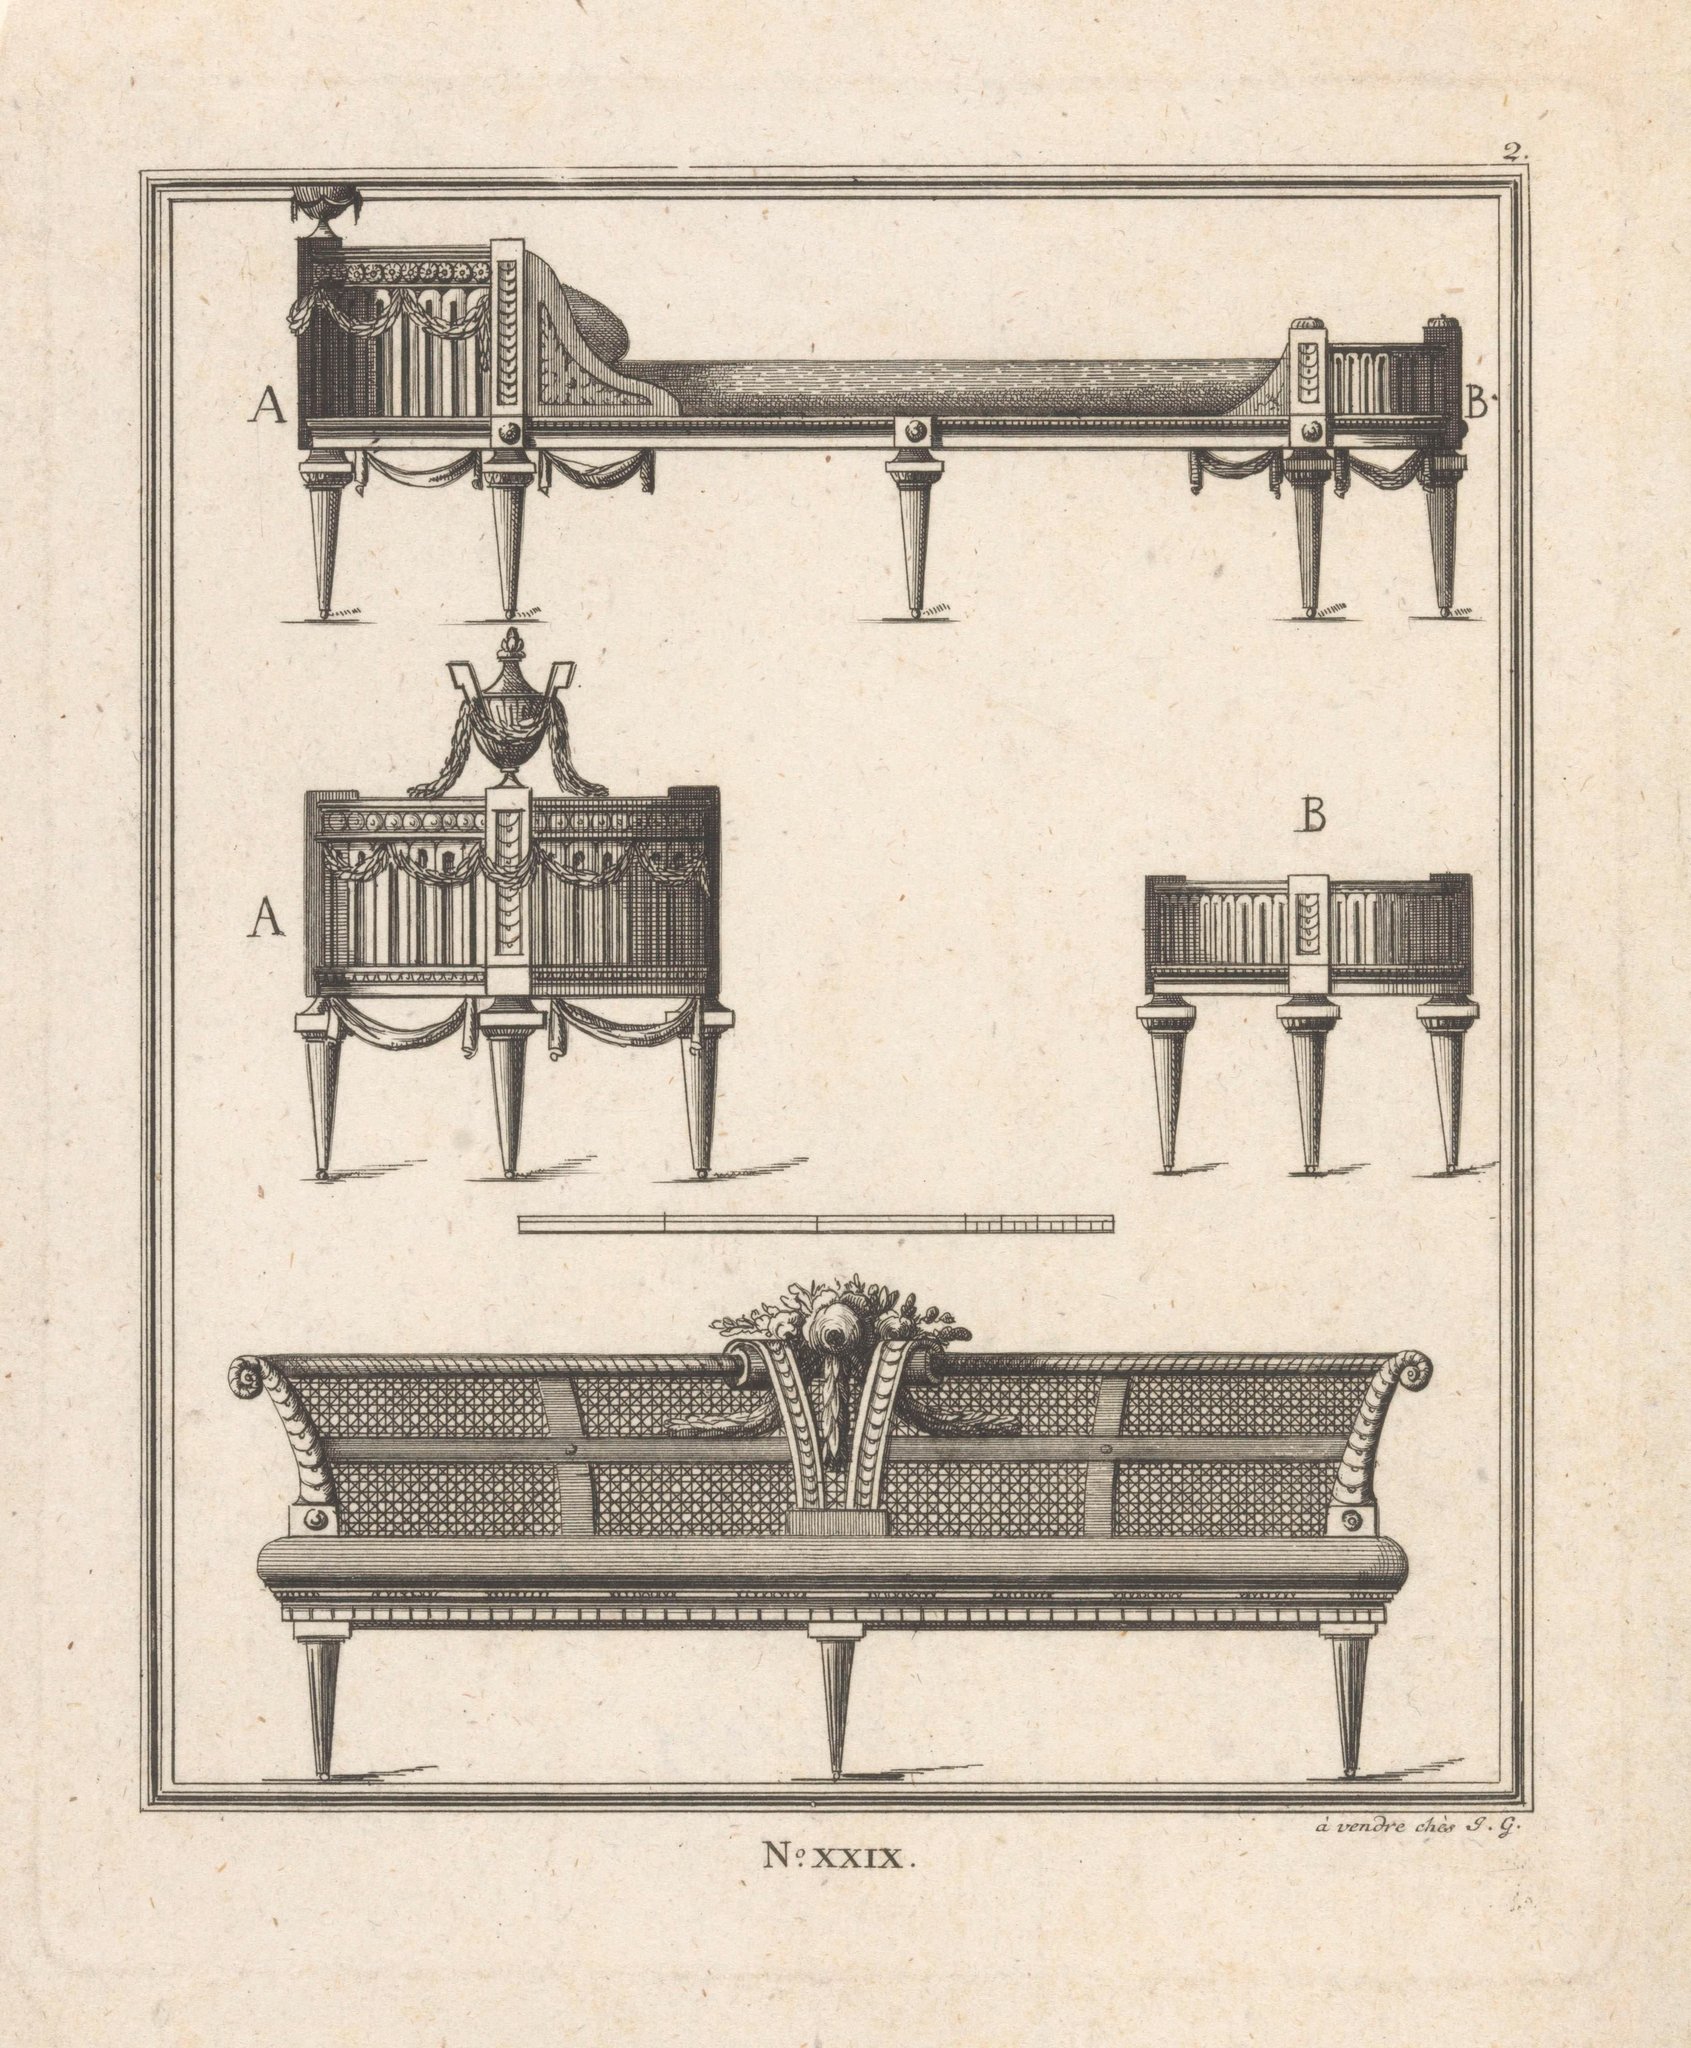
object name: ornament print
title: Diverses Menuiseries à l'antique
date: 1758-1820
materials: paper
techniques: engraving, etching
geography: ravensburg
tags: couch, sofa, settee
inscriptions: collector's mark: Lugt 2760, collector's mark: Lugt 2228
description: Ontwerpen en zijaanzichten van twee antieke divans. Gedecoreerd met ornamenten, guirlandes, een vaas en bloemen. Uitgeversnummer XXIX.